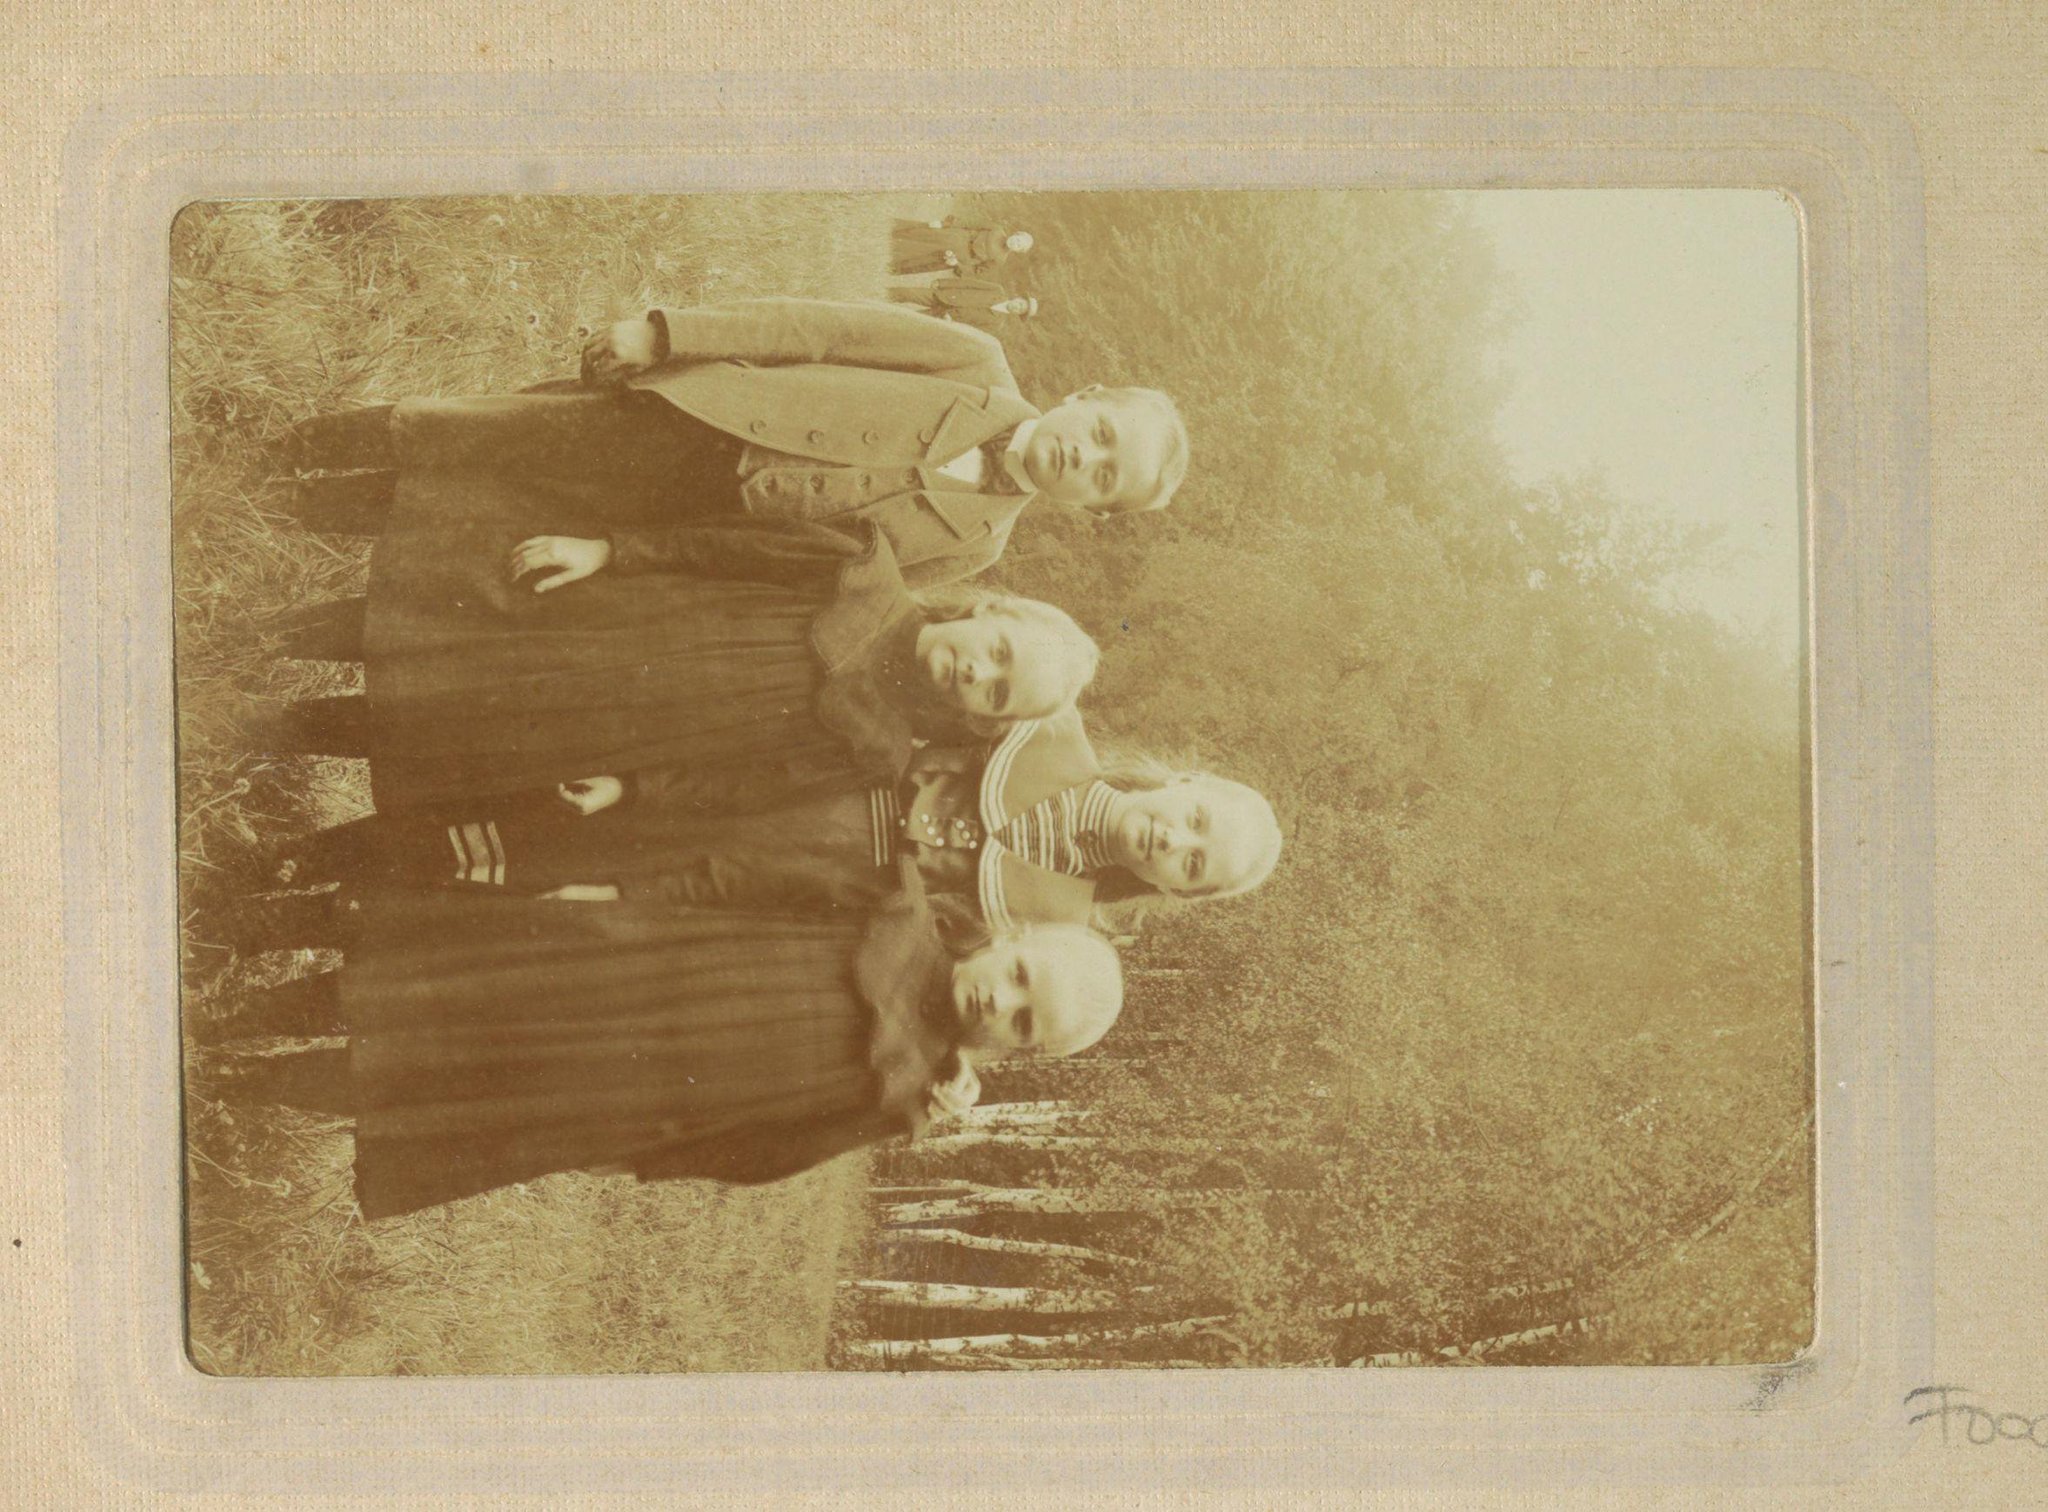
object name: photograph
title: Groepsportret van vier kinderen staand in weide in Duitsland met op de achtergrond twee volwassenen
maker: Anonymous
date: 1890-1910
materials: cardboard, paper, photographic support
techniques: daylight paper print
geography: germany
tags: brothers or sisters (second degree family relationships), germany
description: Onderdeel van Fotoalbum van Carl Heinrich Fliegenschmidt, gevangenisdirecteur te Oslebshausen.